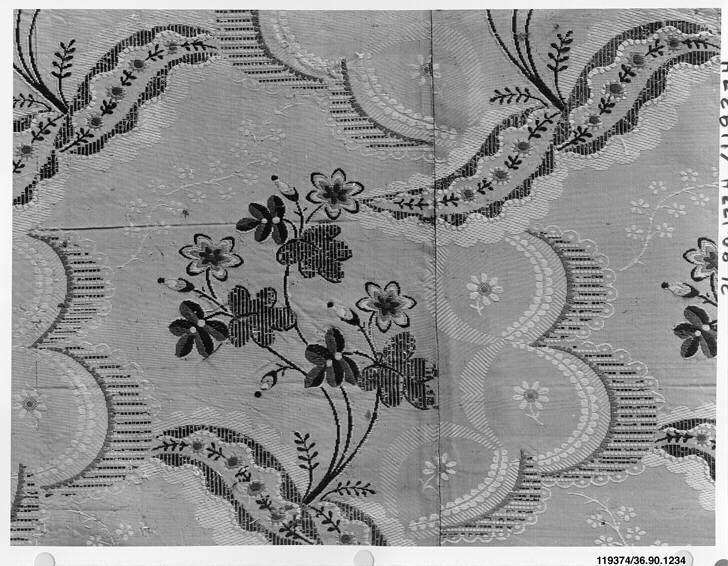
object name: piece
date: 1750-1760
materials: metal thread, silk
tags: flowers,leaves